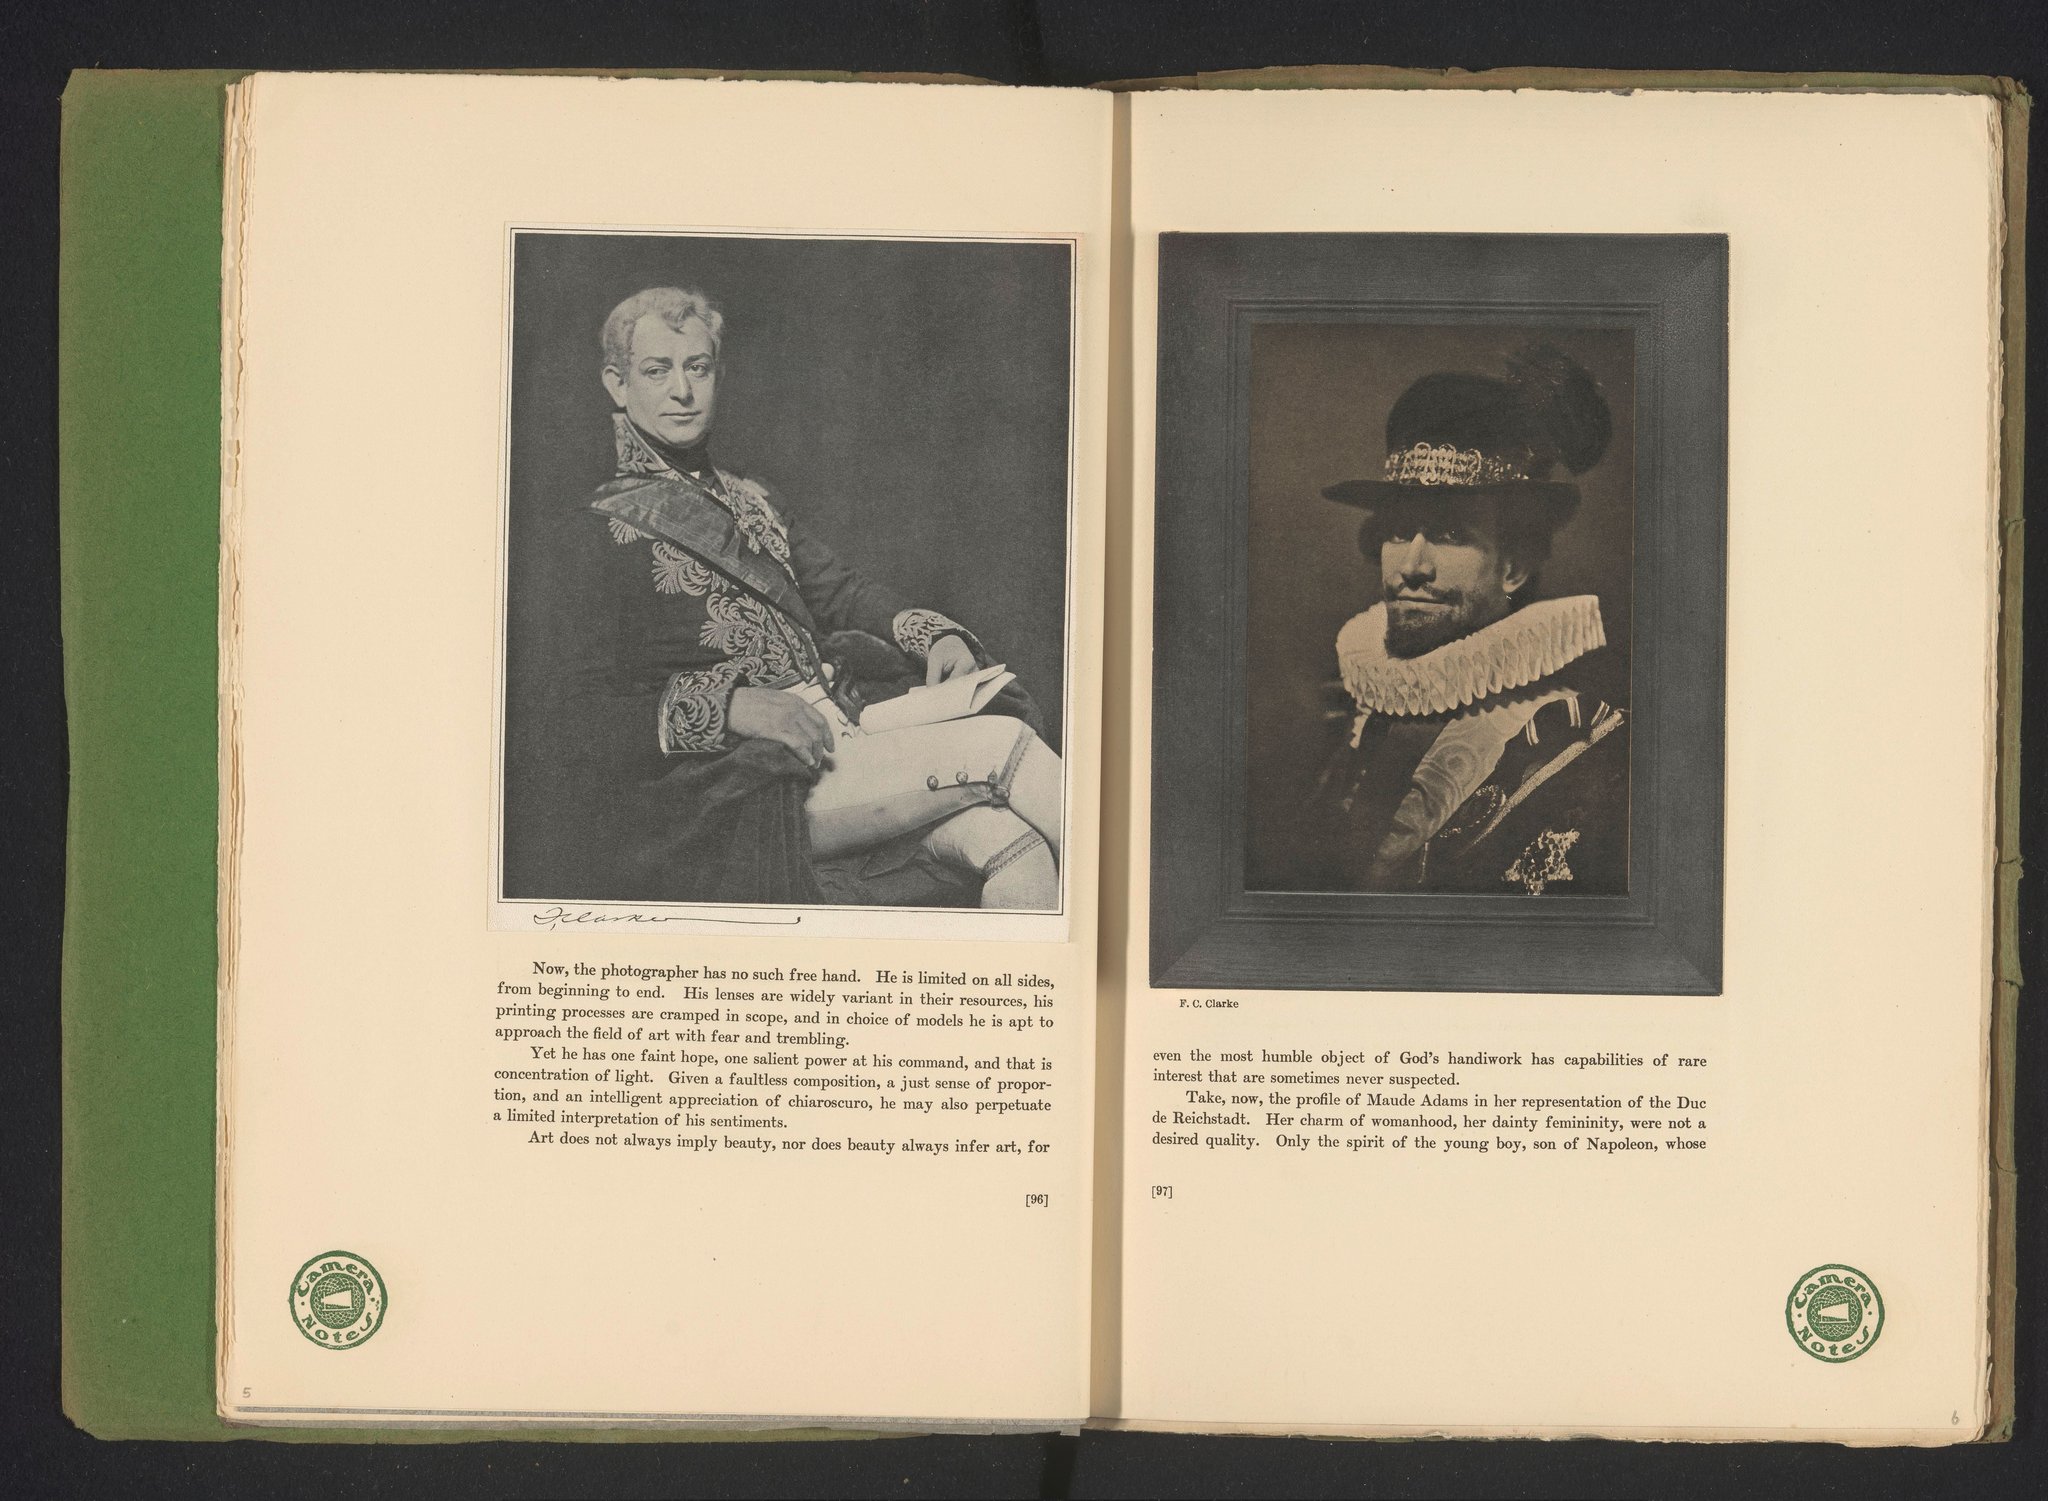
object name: page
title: Portret van een onbekende man in traditionele kledij in lijst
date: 1897-1902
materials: paper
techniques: autotype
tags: clothes for special purposes, frame of painting, etc., historical persons not known by name